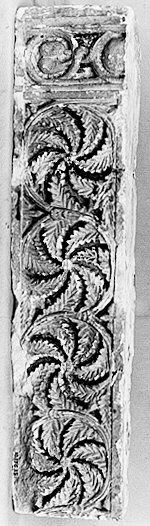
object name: frieze fragment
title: Fragment from a Frieze with Acanthus-Leaf Wheels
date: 501-600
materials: limestone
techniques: carving, relief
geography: egypt